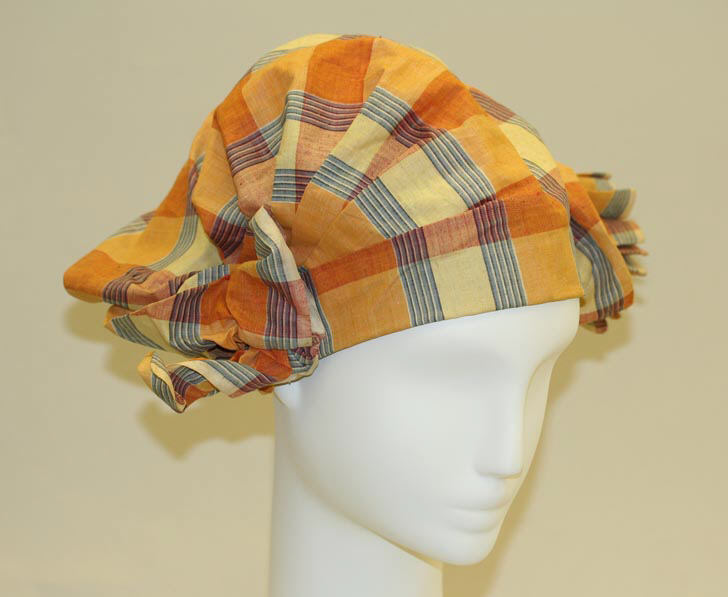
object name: evening turban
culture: american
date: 1823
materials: cotton